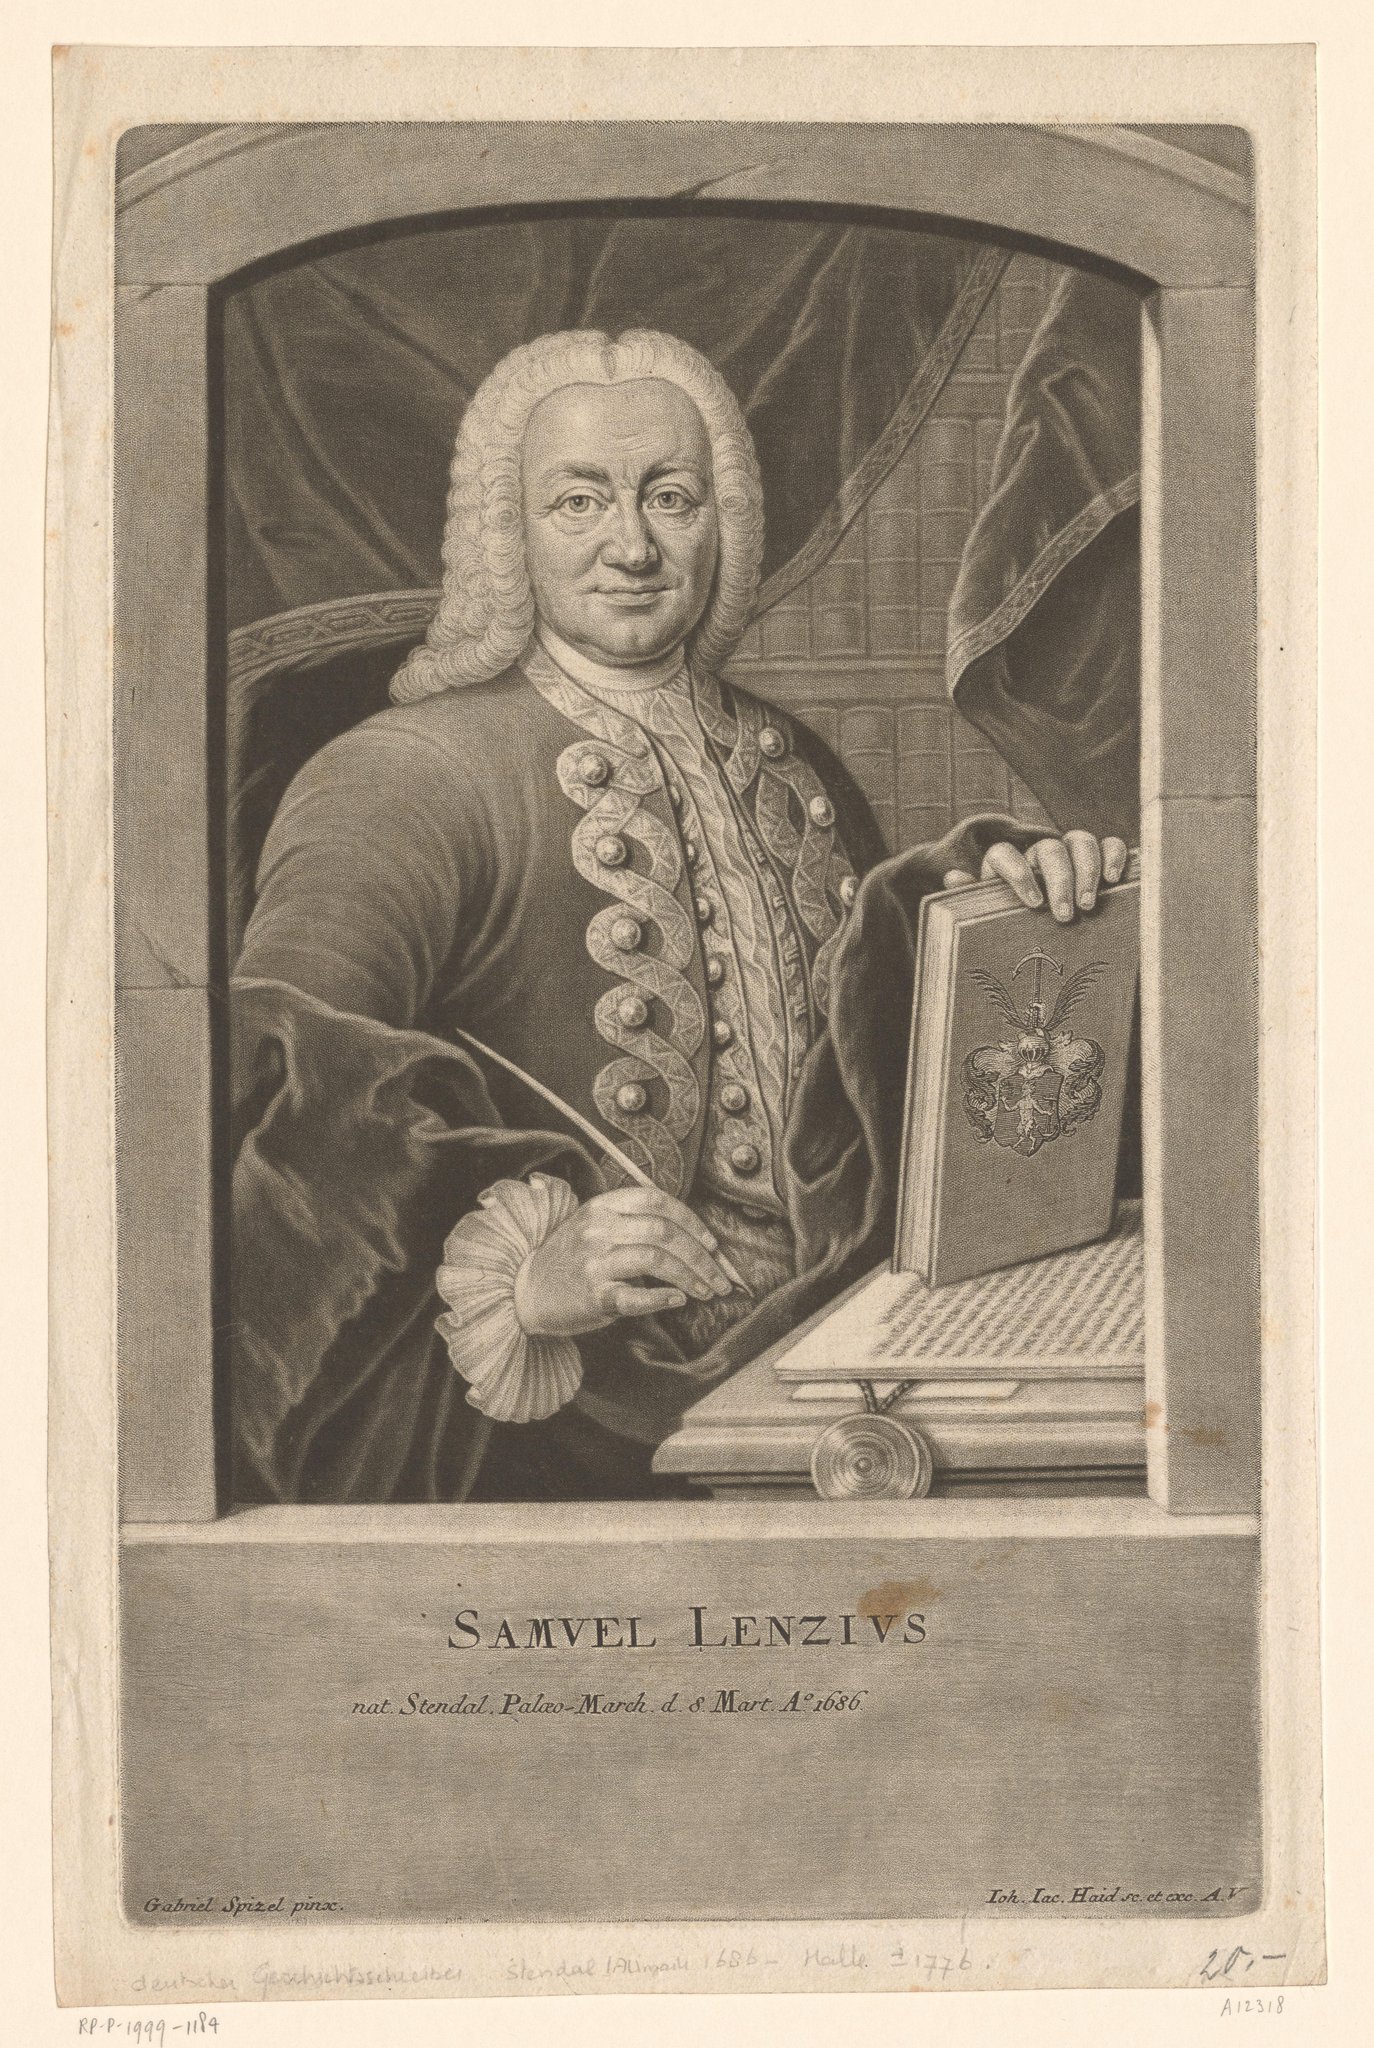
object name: print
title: Samuel Lenzius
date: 1752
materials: paper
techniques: engraving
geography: augsburg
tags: bookshelves, historical persons, book, pencil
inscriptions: collector's mark: Lugt 2228, inscription: ‘Portr. 60018’, collector's mark: Lugt 2760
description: Prent waarschijnlijk uit: Brucker, Jacob. Bilder-sal heutiges Tages lebender und durch Gelahrheit berühmter Schrifft-steller (...). Augsburg: Johann Jacob Haid, 1752, dl. 9.